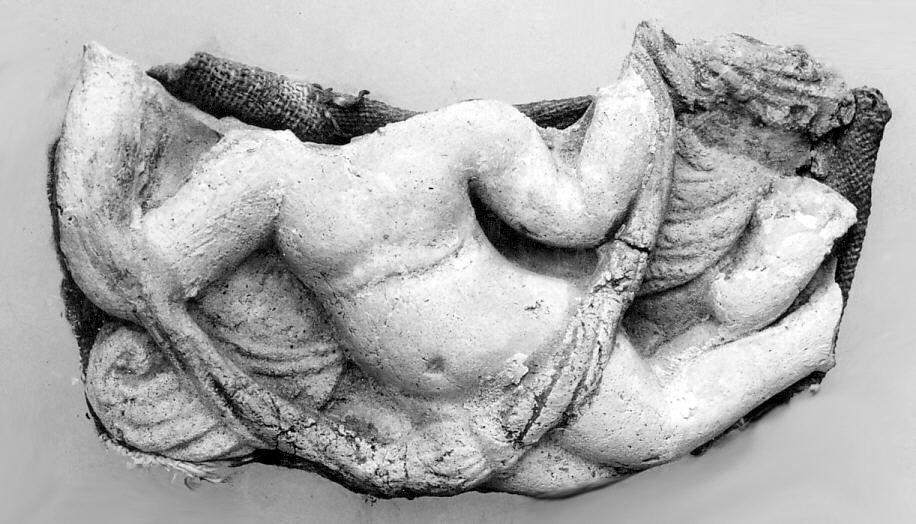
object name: relief fragment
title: Fragment of a Relief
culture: central asian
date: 701-800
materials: plaster